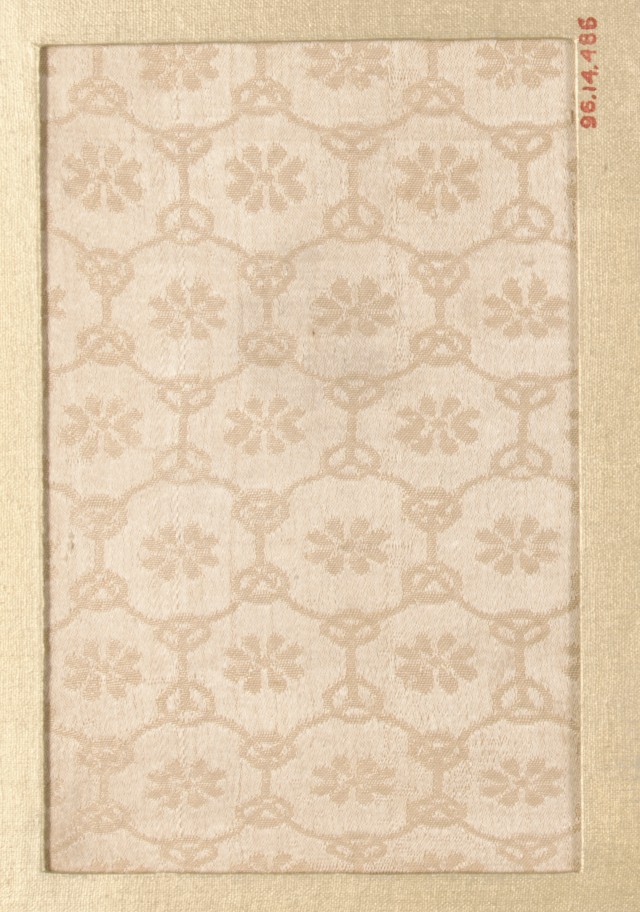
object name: piece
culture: japanese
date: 1701-1900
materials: silk